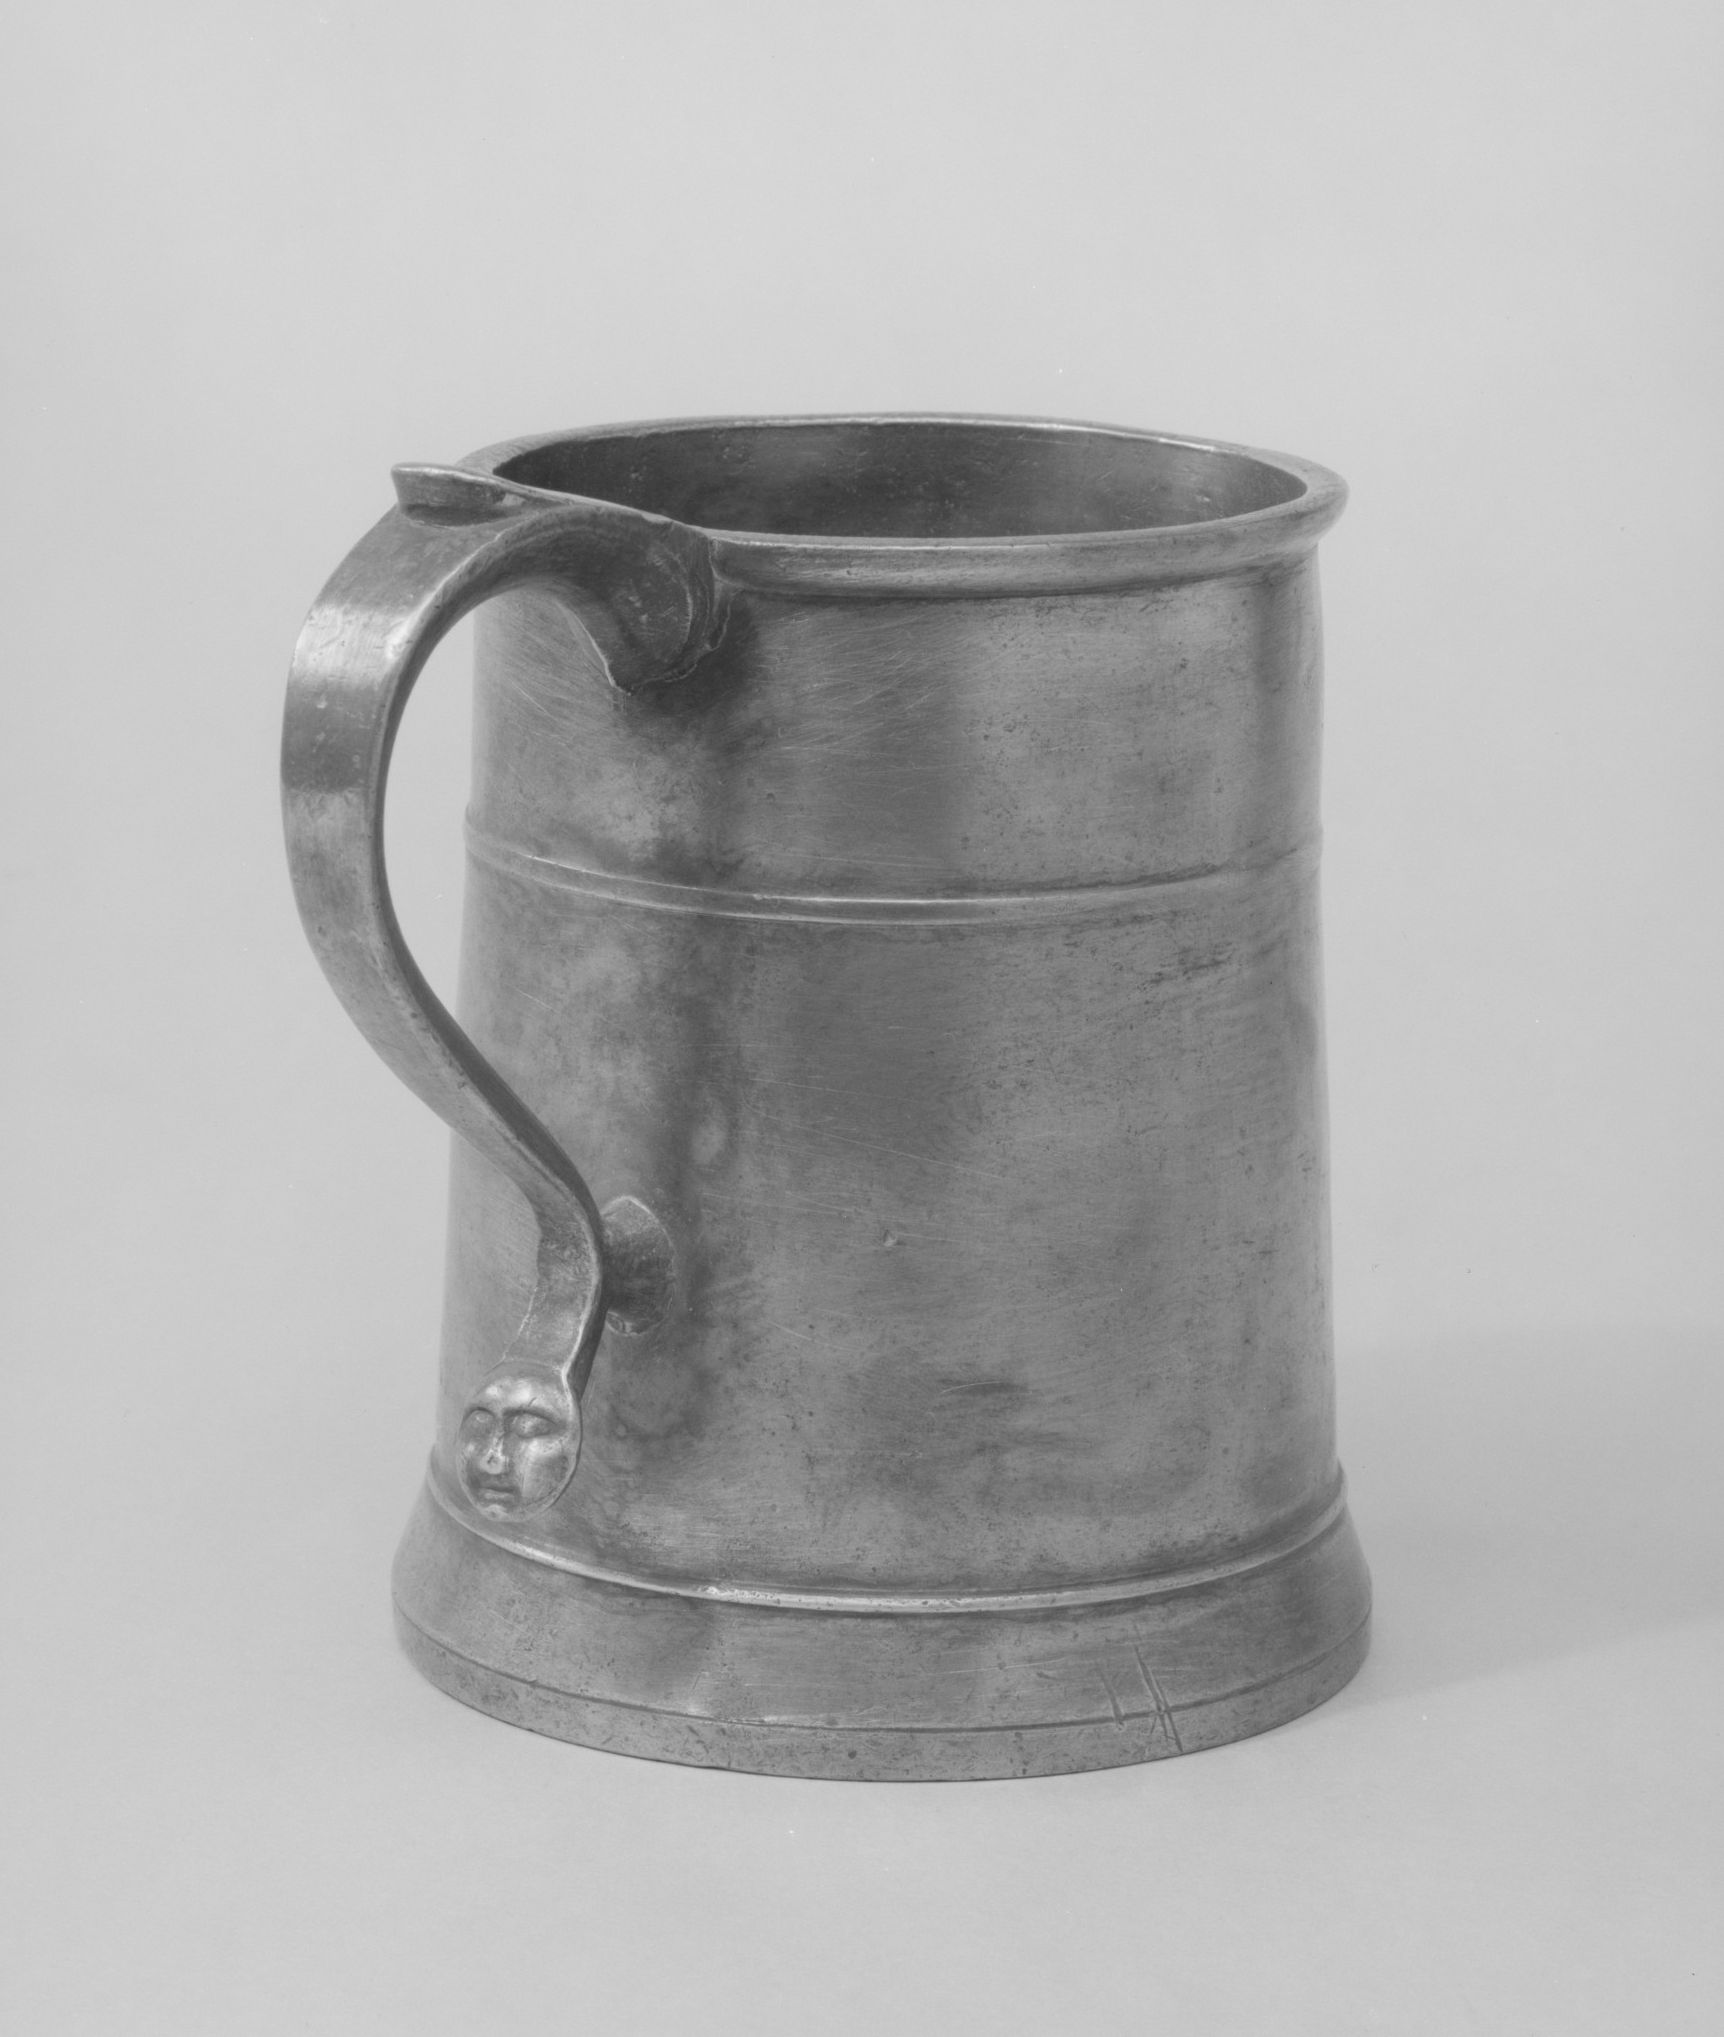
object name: pint mug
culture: american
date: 1770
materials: pewter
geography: united states